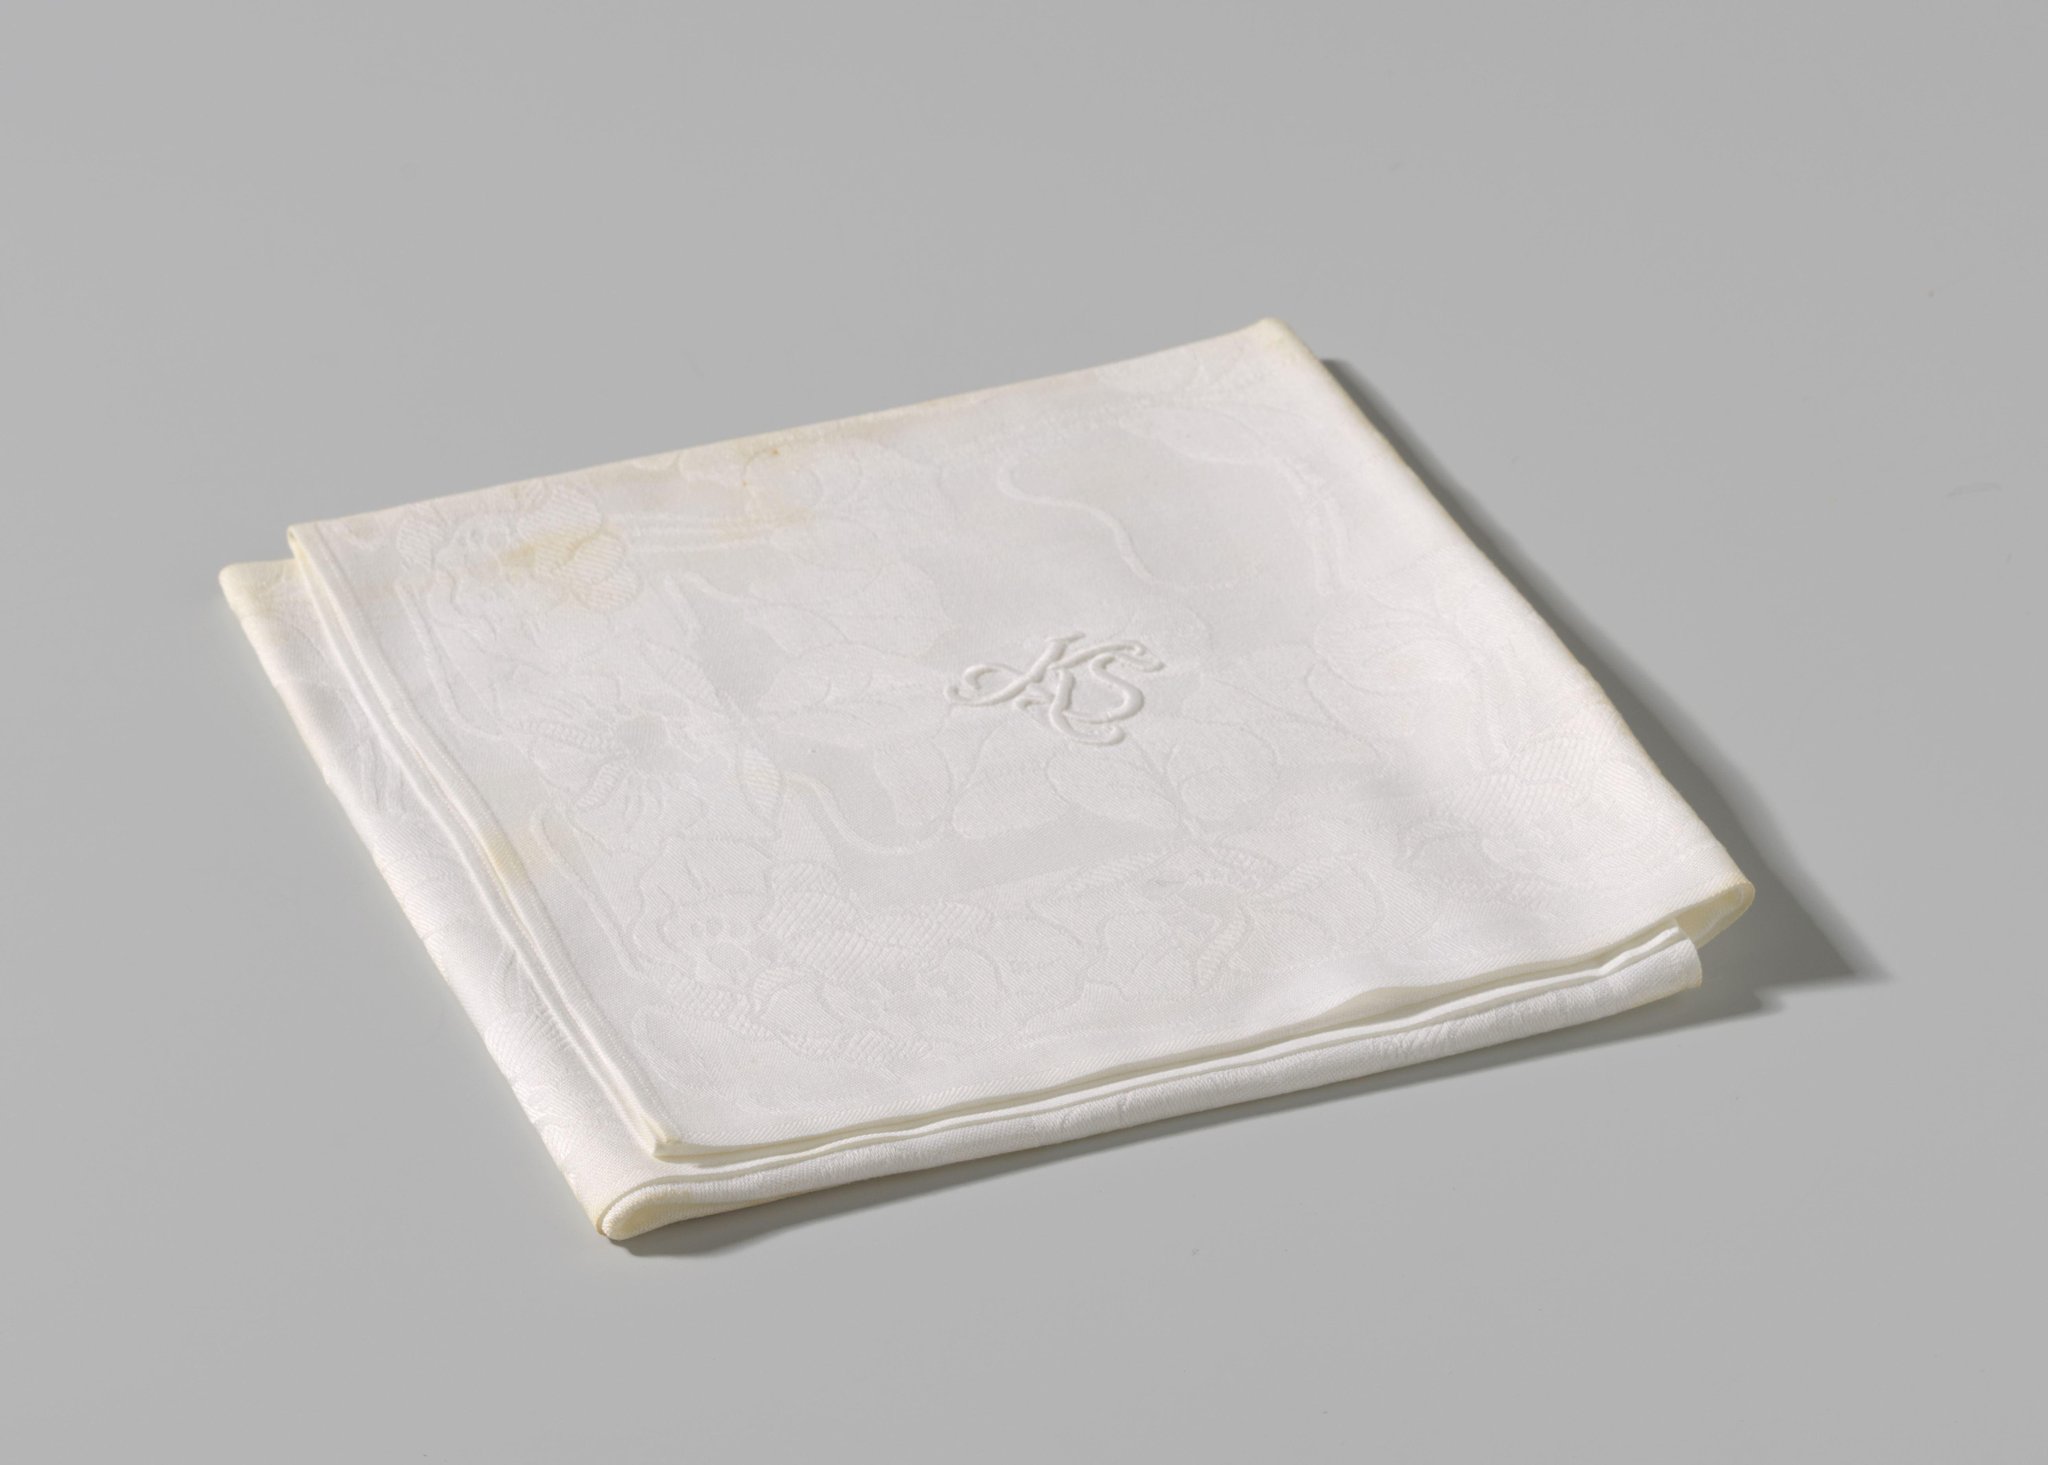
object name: napkin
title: Servet van linnendamast met bladeren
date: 1890-1910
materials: linen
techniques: damask, weave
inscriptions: mark: ‘KUP’, number: ‘2559’, monogram: ‘KS’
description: Servet van linnendamast met bladeren aan kronkelende stengels en een rand van gestileerde bloemen. Het servet heeft een aangenaaid nummer (2559 in rood op wit) en een in wit geborduurd monogram KS. Het servet hoort bij vijf servetten (BK-1970-129-B t/m BK-1970-129-G) en een tafellaken (BK-1970-129-A).